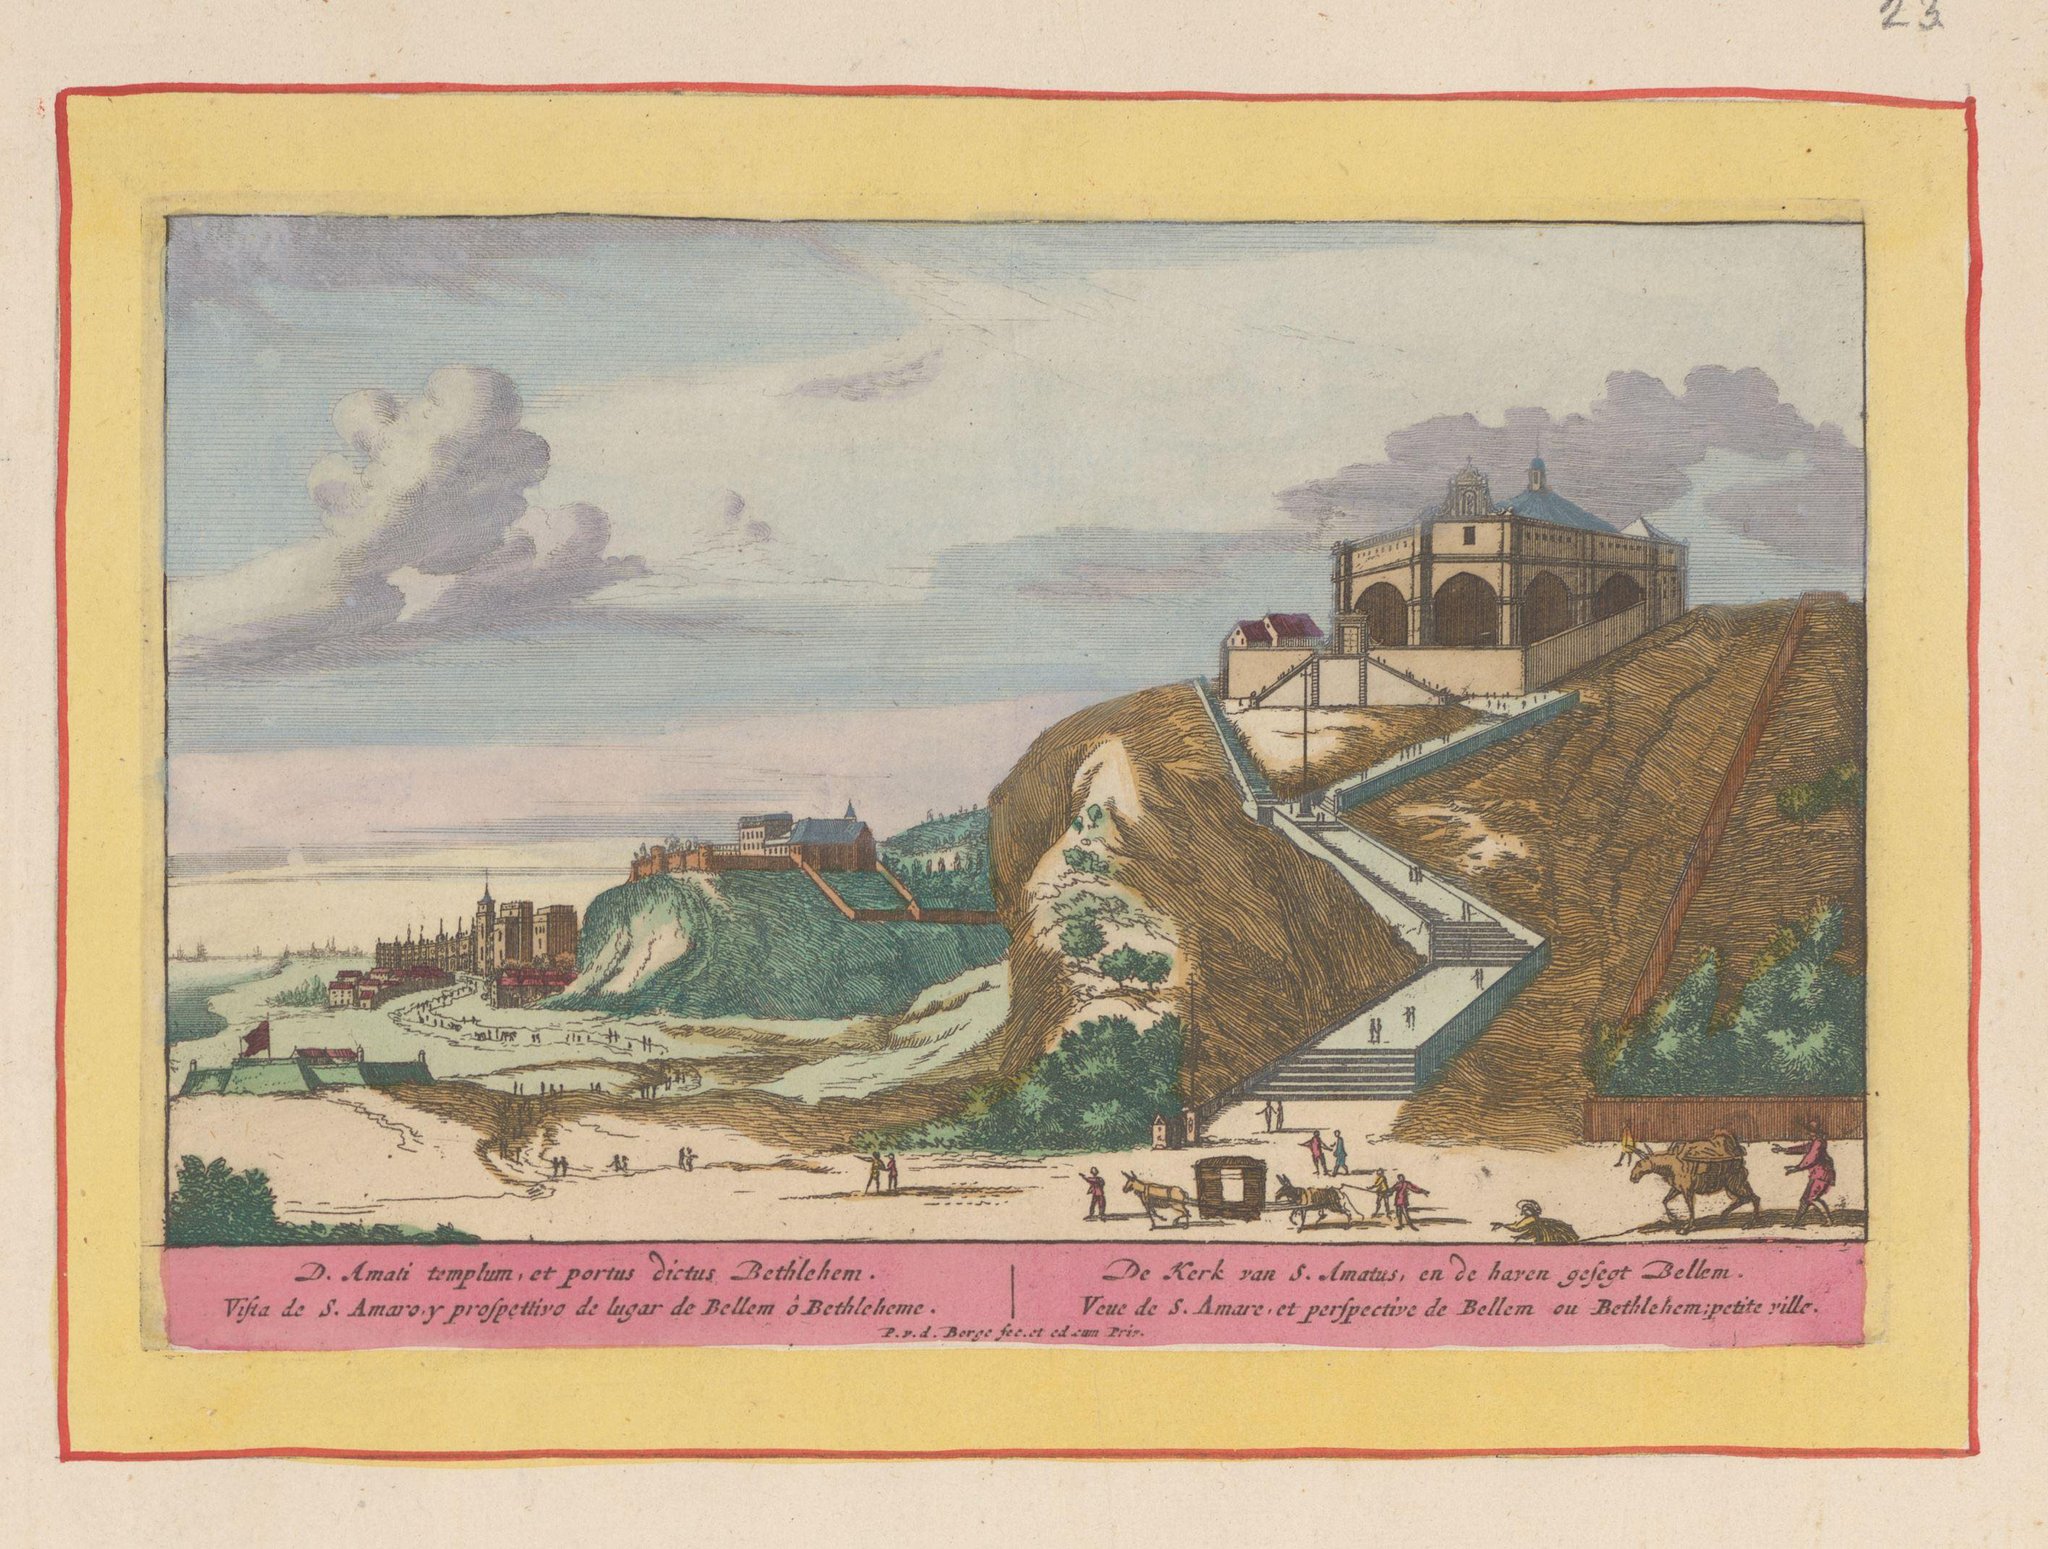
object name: book illustration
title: De Kerk van S. Amatus, en de haven gesegt Bellem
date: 1694-1737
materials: paper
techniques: etching, hand coloring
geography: the hague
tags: church (exterior)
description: Prent uit: Theatrum Hispaniæ, exhibens regni urbes, villas ac viridaria magis illustria. Het aanmerkelykste en voortreffelykste in Spanjen (...). Amsterdam: Pieter van den Berge, ca. 1694-1737.